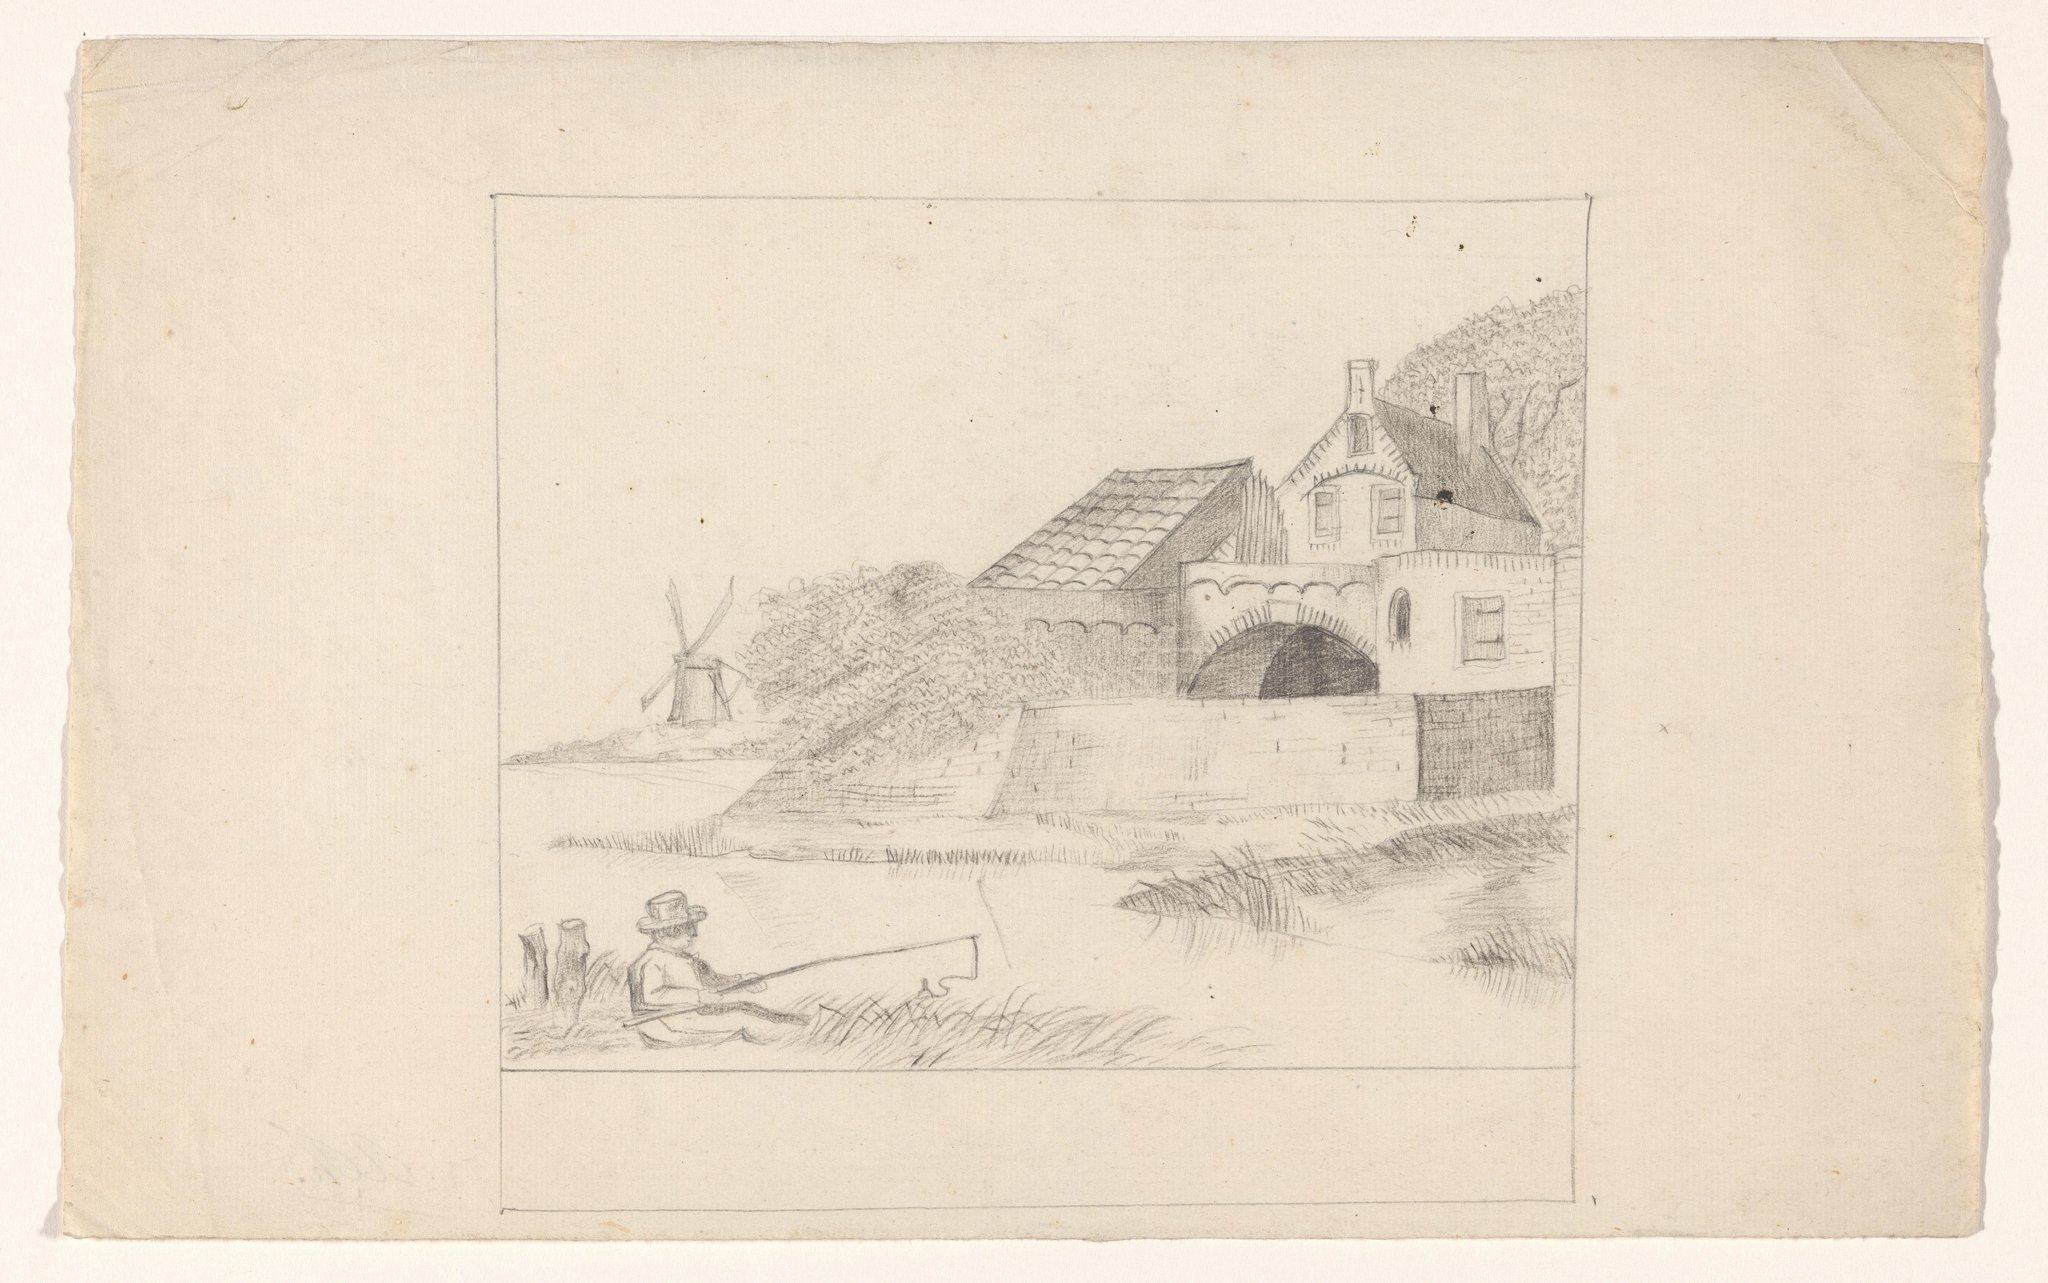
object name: drawing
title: Visser bij een vesting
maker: joannes carolus alberdingk thijm (jan)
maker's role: pater, schrijver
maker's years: 1847-1926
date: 1853-1860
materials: chalk, paper, pencil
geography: netherlands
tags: fortress, castle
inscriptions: inscription: ‘A.Th.’